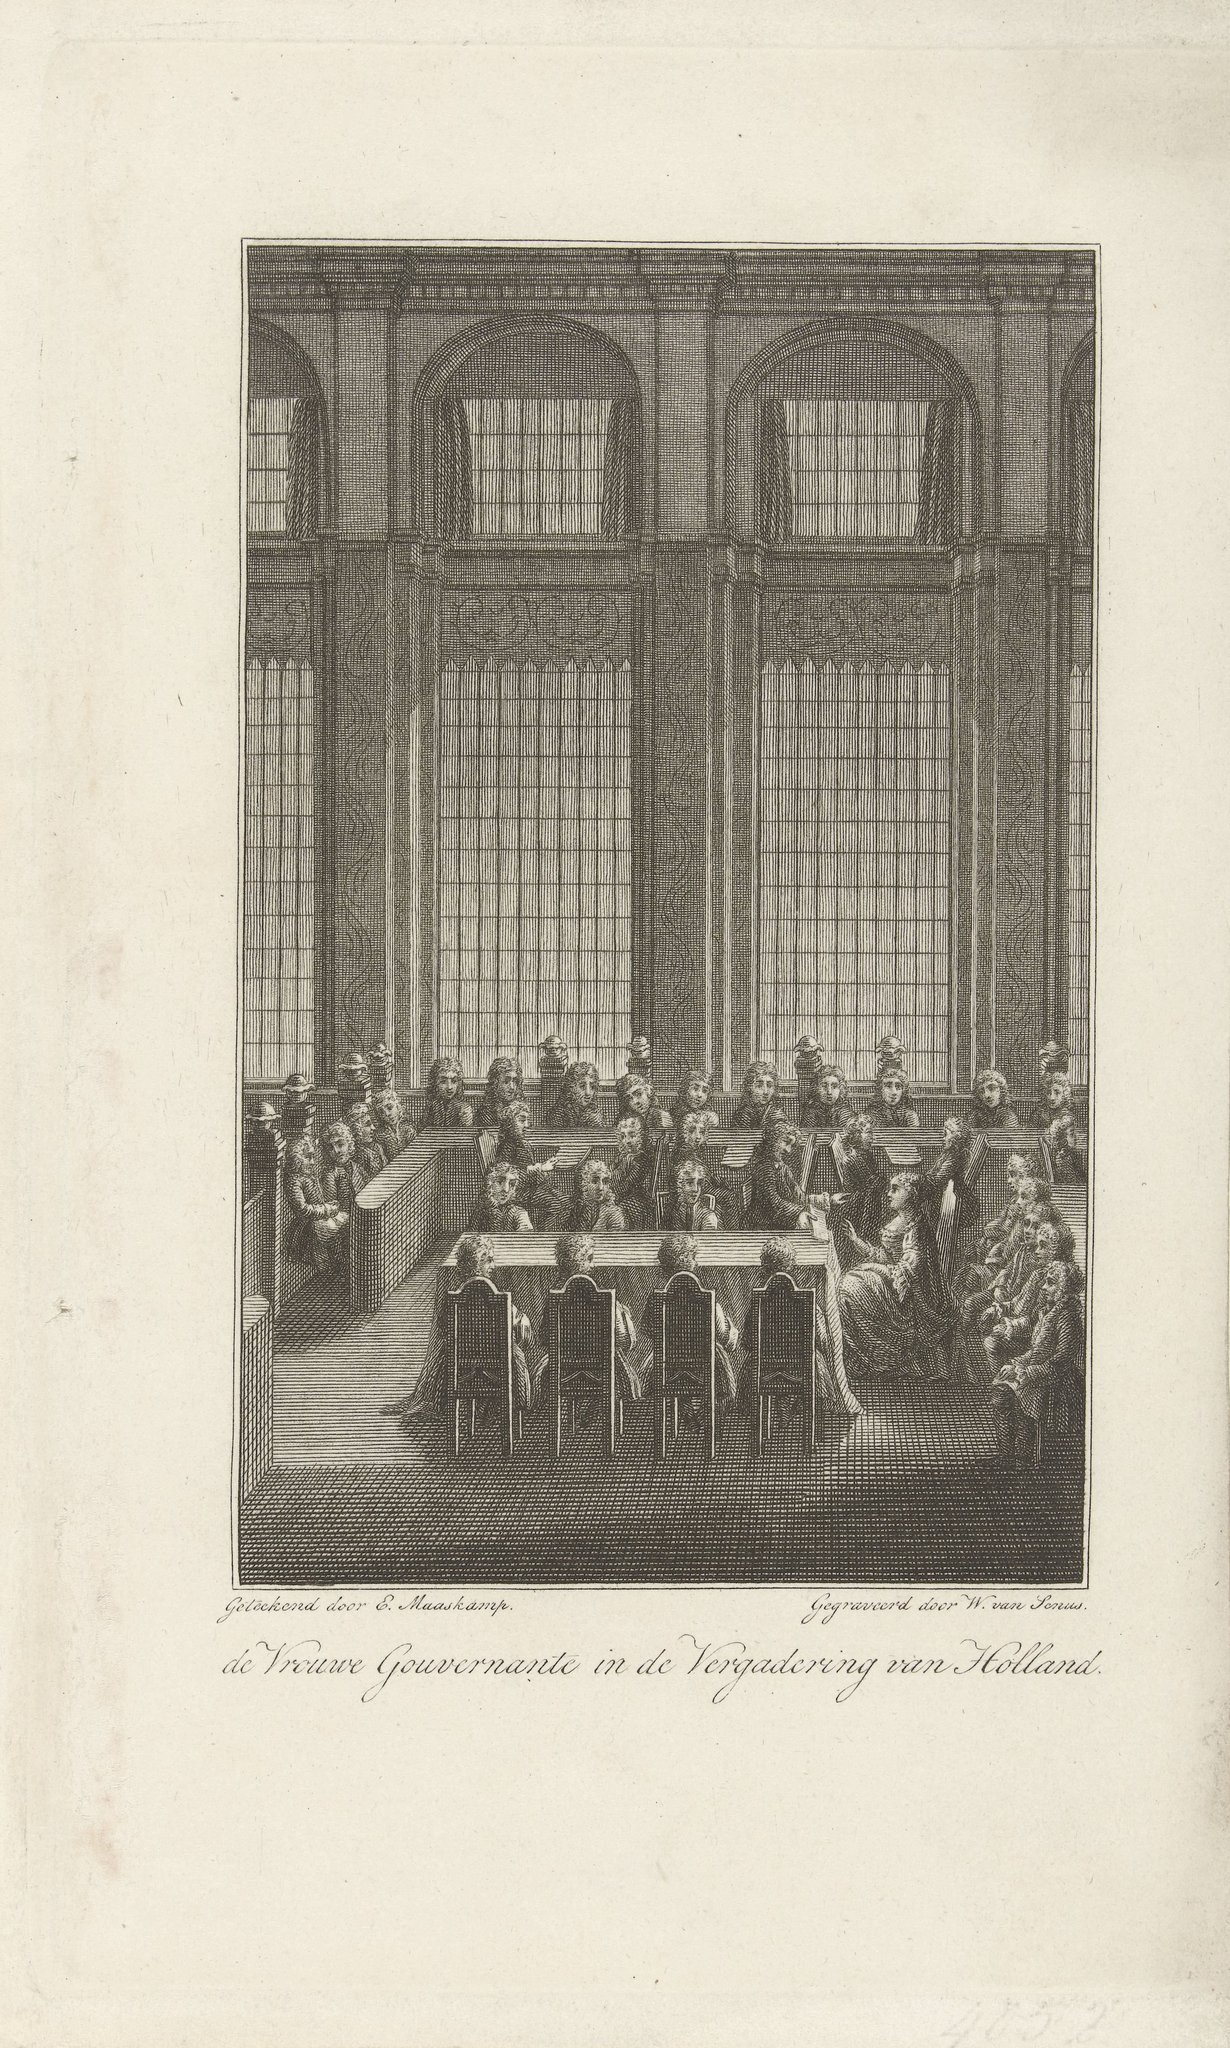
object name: history print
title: de Vrouwe Gouvernante in de Vergadering van Holland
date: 1819-1821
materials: paper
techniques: engraving, etching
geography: northern netherlands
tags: william v (prince of orange), anna van hannover, lower house, parliament, chamber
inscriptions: collector's mark: Lugt 2228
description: Gebruikt als illustratie in: Martinus Stuart. Vaderlandsche historie, vervattende de geschiedenissen der Vereenigde Nederlanden. Amsterdam: Evert Maaskamp, 1821-1826.